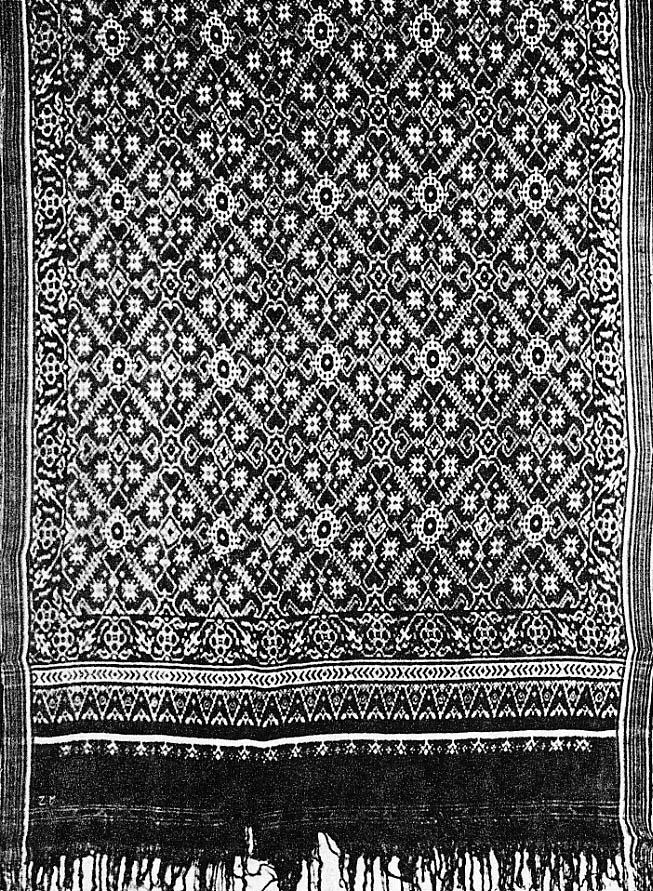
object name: patolu sari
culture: indian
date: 1801-1900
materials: foil, silk, silver